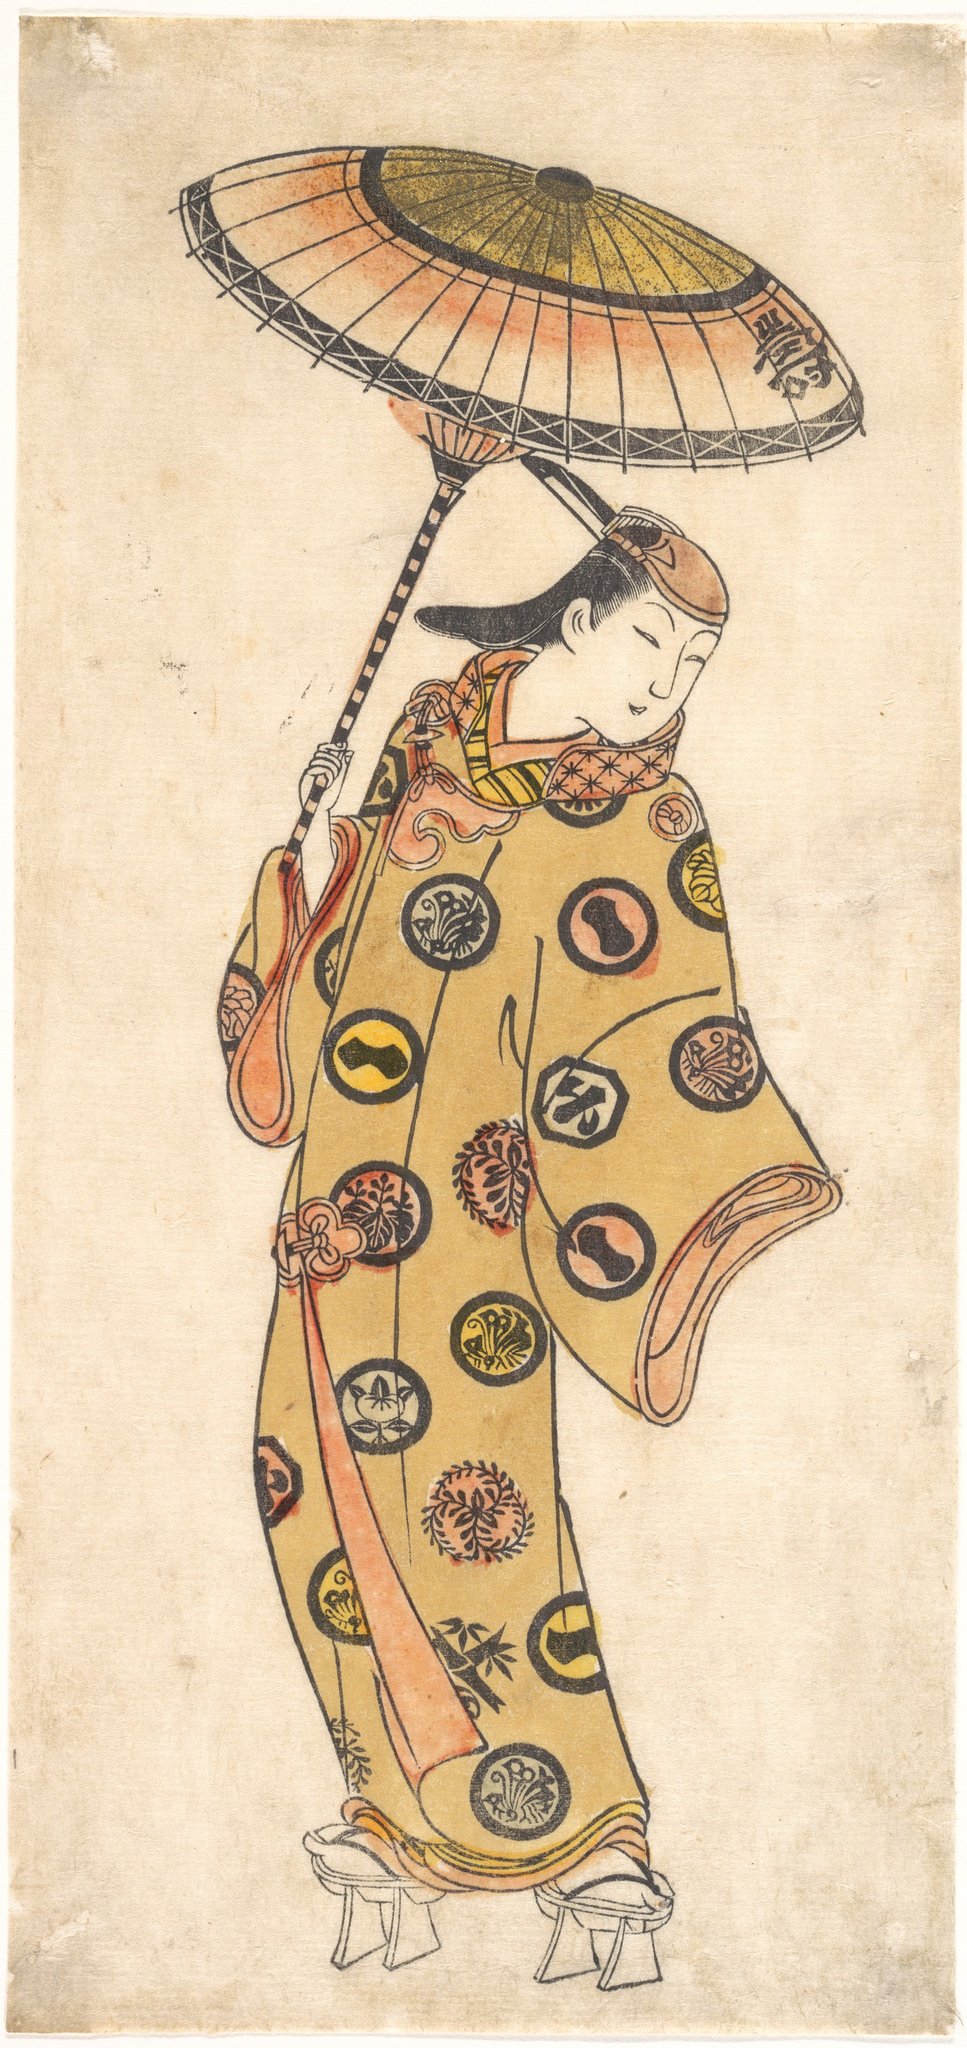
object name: print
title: A Dandy of More Than Questionable Morals Out Walking on a Cold Day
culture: japanese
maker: ishikawa toyonobu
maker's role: artist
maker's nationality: japanese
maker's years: 1711-1785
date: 1728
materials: ink, paper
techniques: hand coloring, woodblock print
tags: men,umbrellas